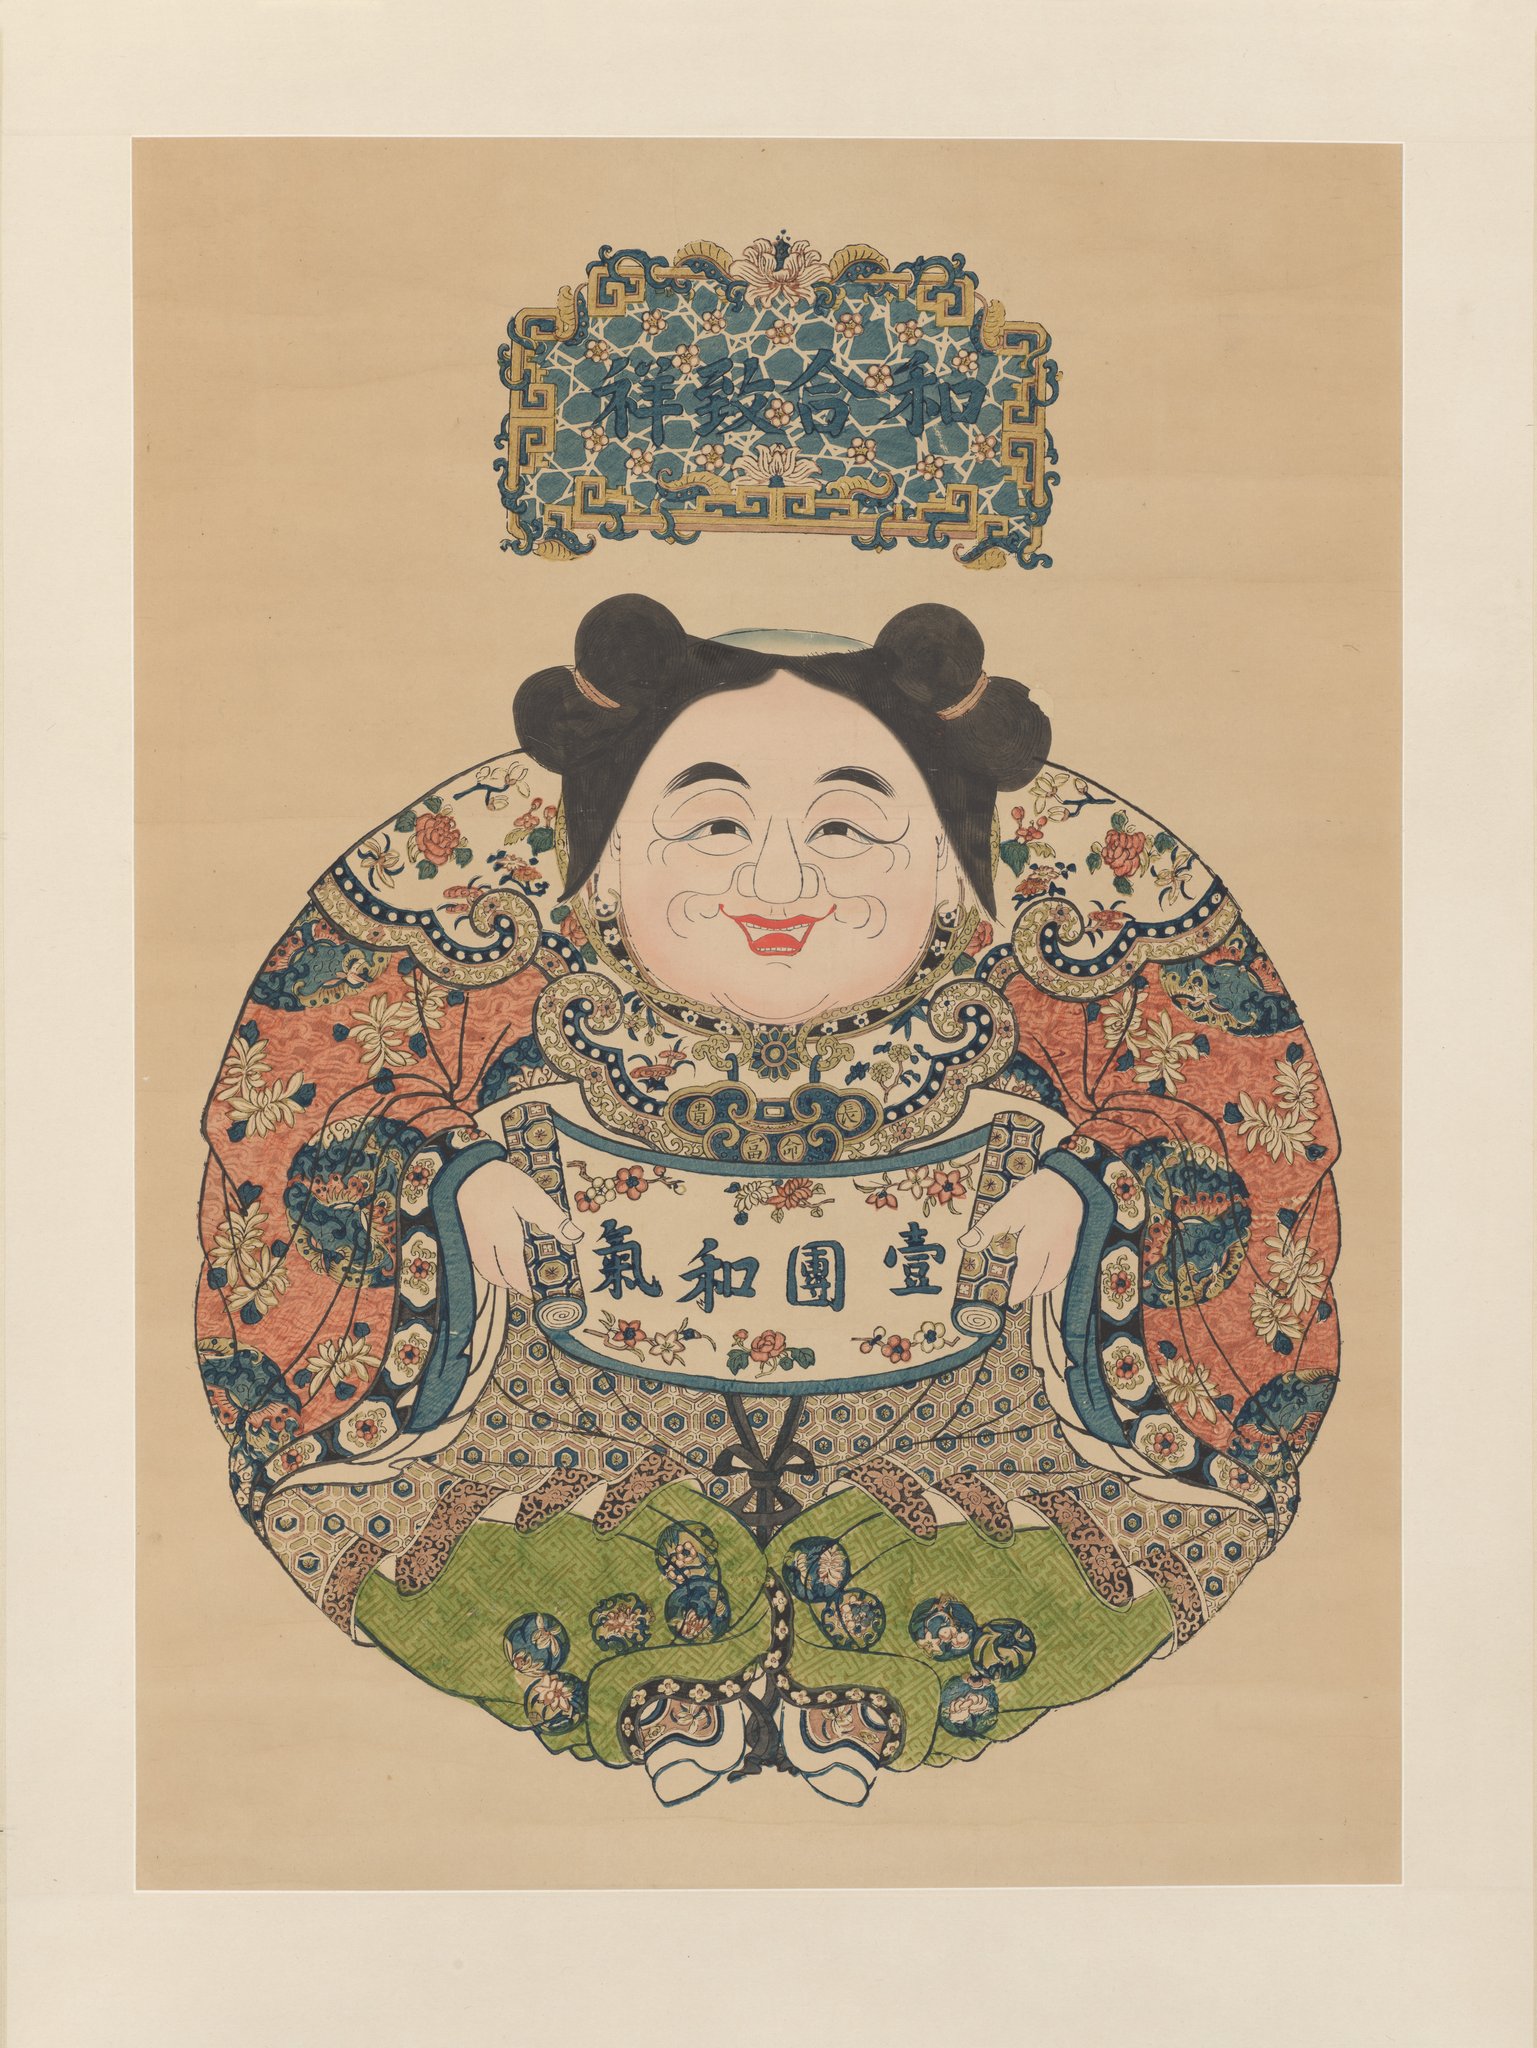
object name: print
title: A Prevailing Mood of Harmony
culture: chinese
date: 1736-1795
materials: ink, paper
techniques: hand coloring, woodblock print